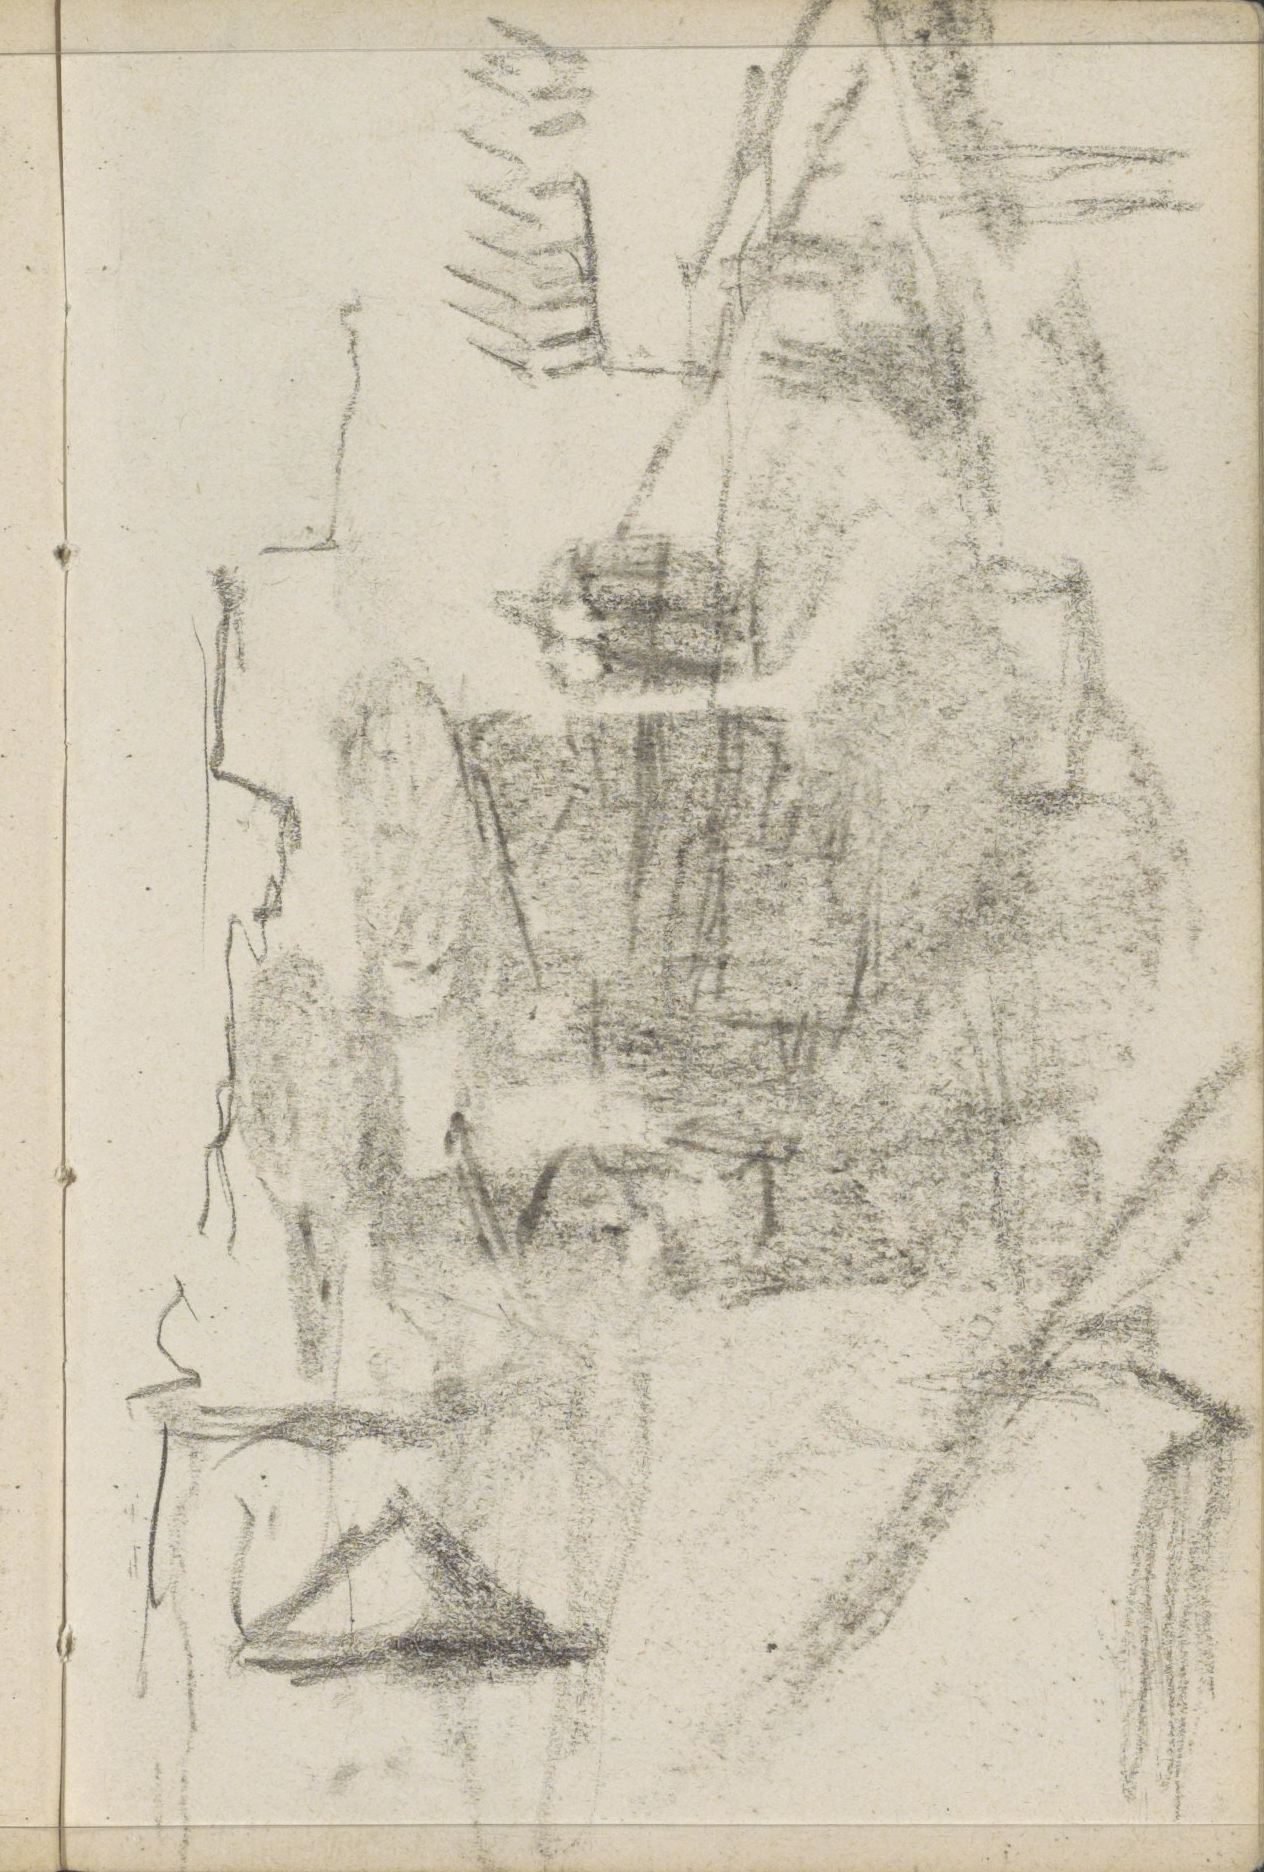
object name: sketchbook leaf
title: Studie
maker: george hendrik breitner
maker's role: draughtsman, painter, print maker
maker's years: 1857-1923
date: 1909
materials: chalk, paper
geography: amsterdam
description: Studie. Pagina 80 uit een schetsboek met 45 bladen vervaardigd in Amsterdam en Pittsburgh.